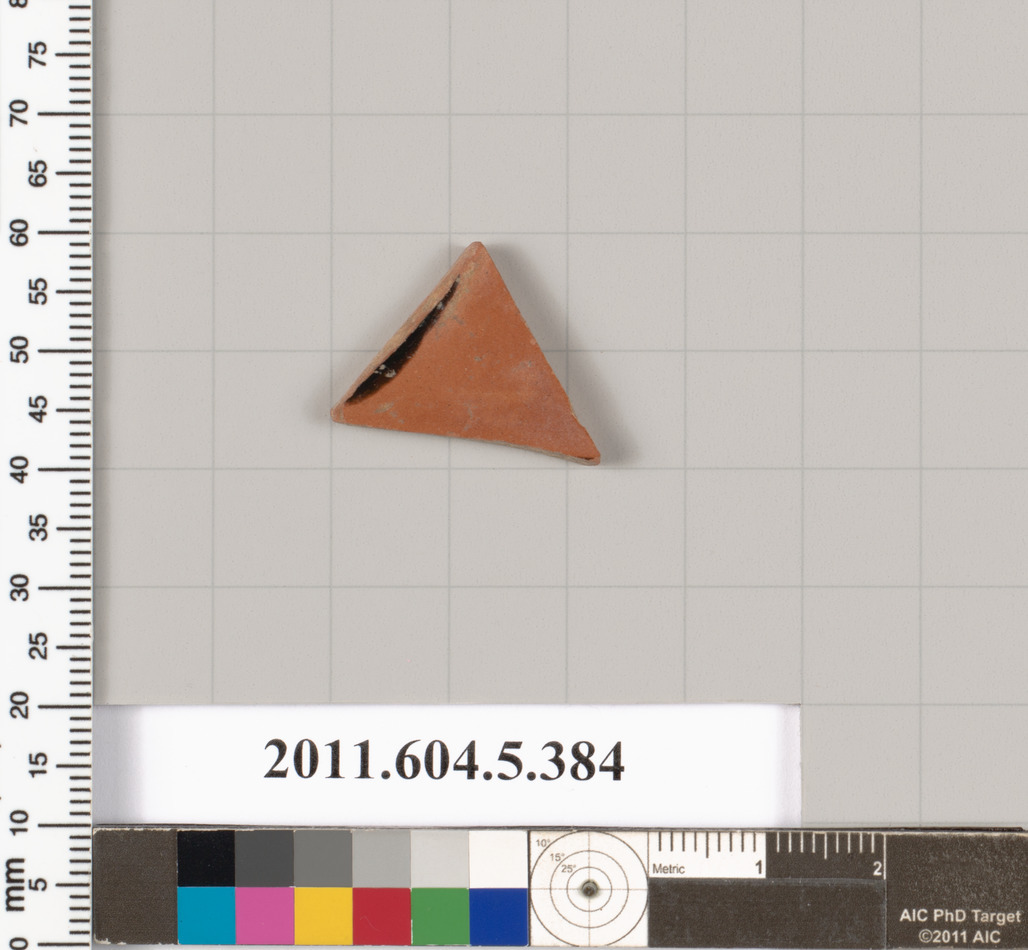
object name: kylix fragment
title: Terracotta fragment of a kylix (drinking cup)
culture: greek, attic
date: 600-401 BCE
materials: terracotta